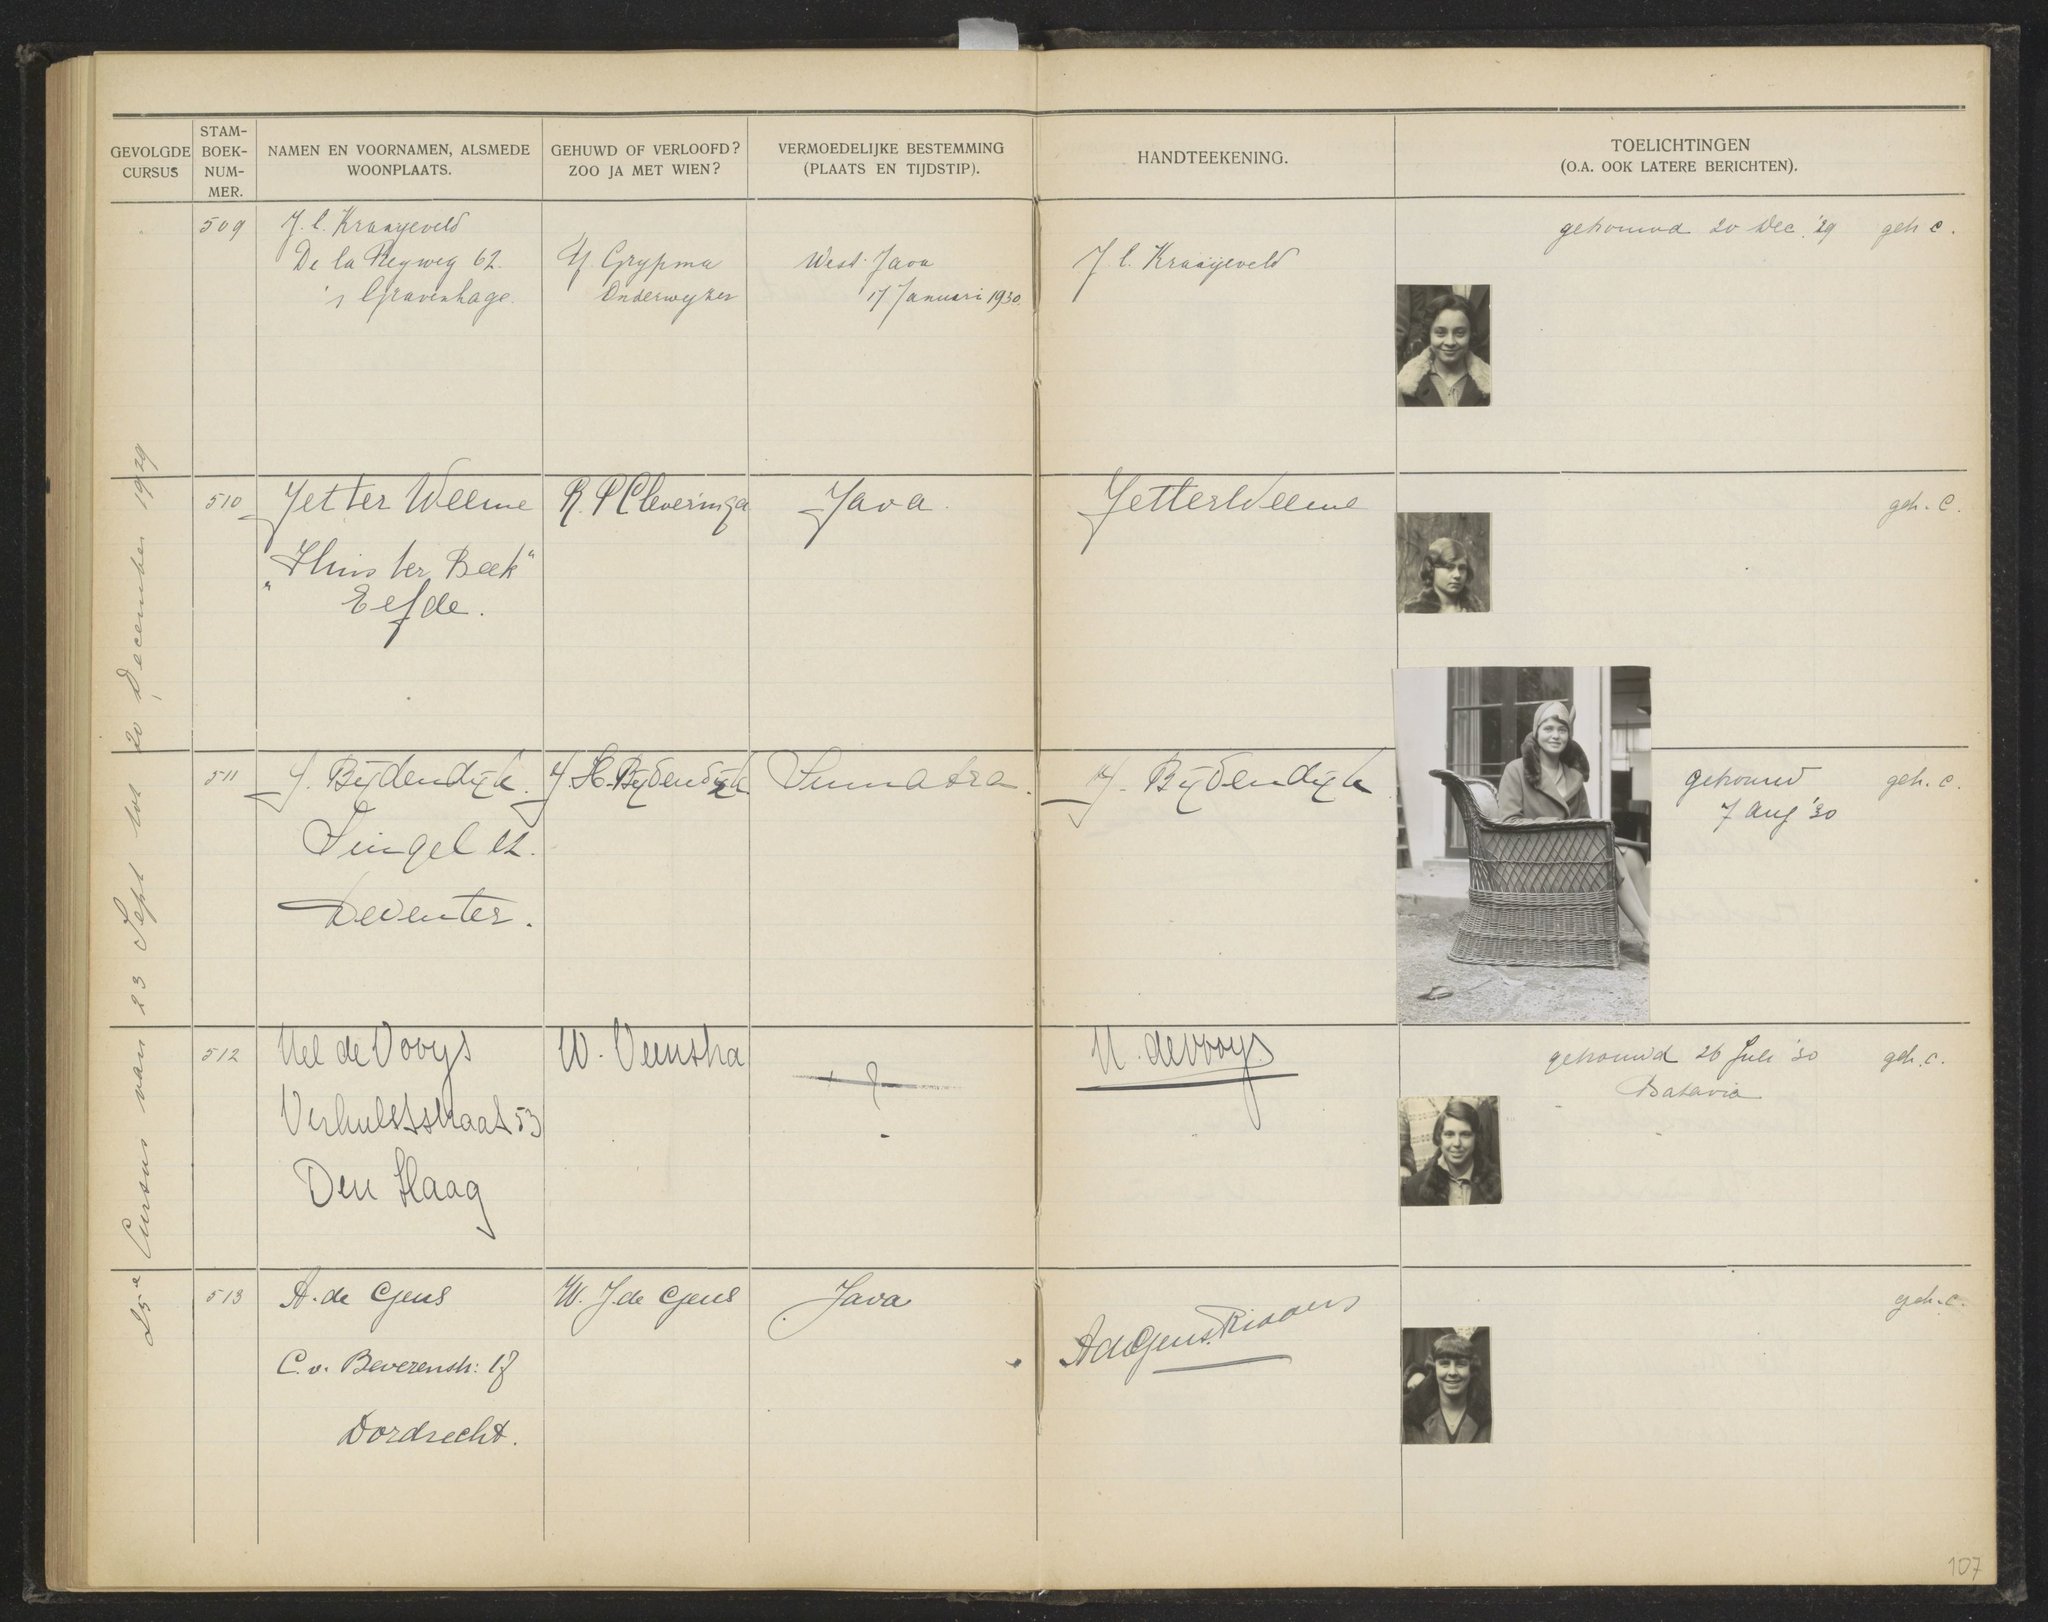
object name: album leaf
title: Blad 107 uit Stamboek van de leerlingen der Koloniale School voor Meisjes en Vrouwen te 's-Gravenhage deel I (1921-1929)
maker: Anonymous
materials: paper, photographic support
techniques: photography, printing, writing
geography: the hague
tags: further education (+ pupil), further education, the hague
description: Twee pagina's met gegevens van de deelnemers aan de 25e driemaandelijkse cursus van 23 september tot en met 20 december 1929, stamboeknummers 509 tot en met 513. Onderdeel van Stamboek van de leerlingen der Koloniale School voor Meisjes en Vrouwen te 's-Gravenhage deel I (1921-1929).